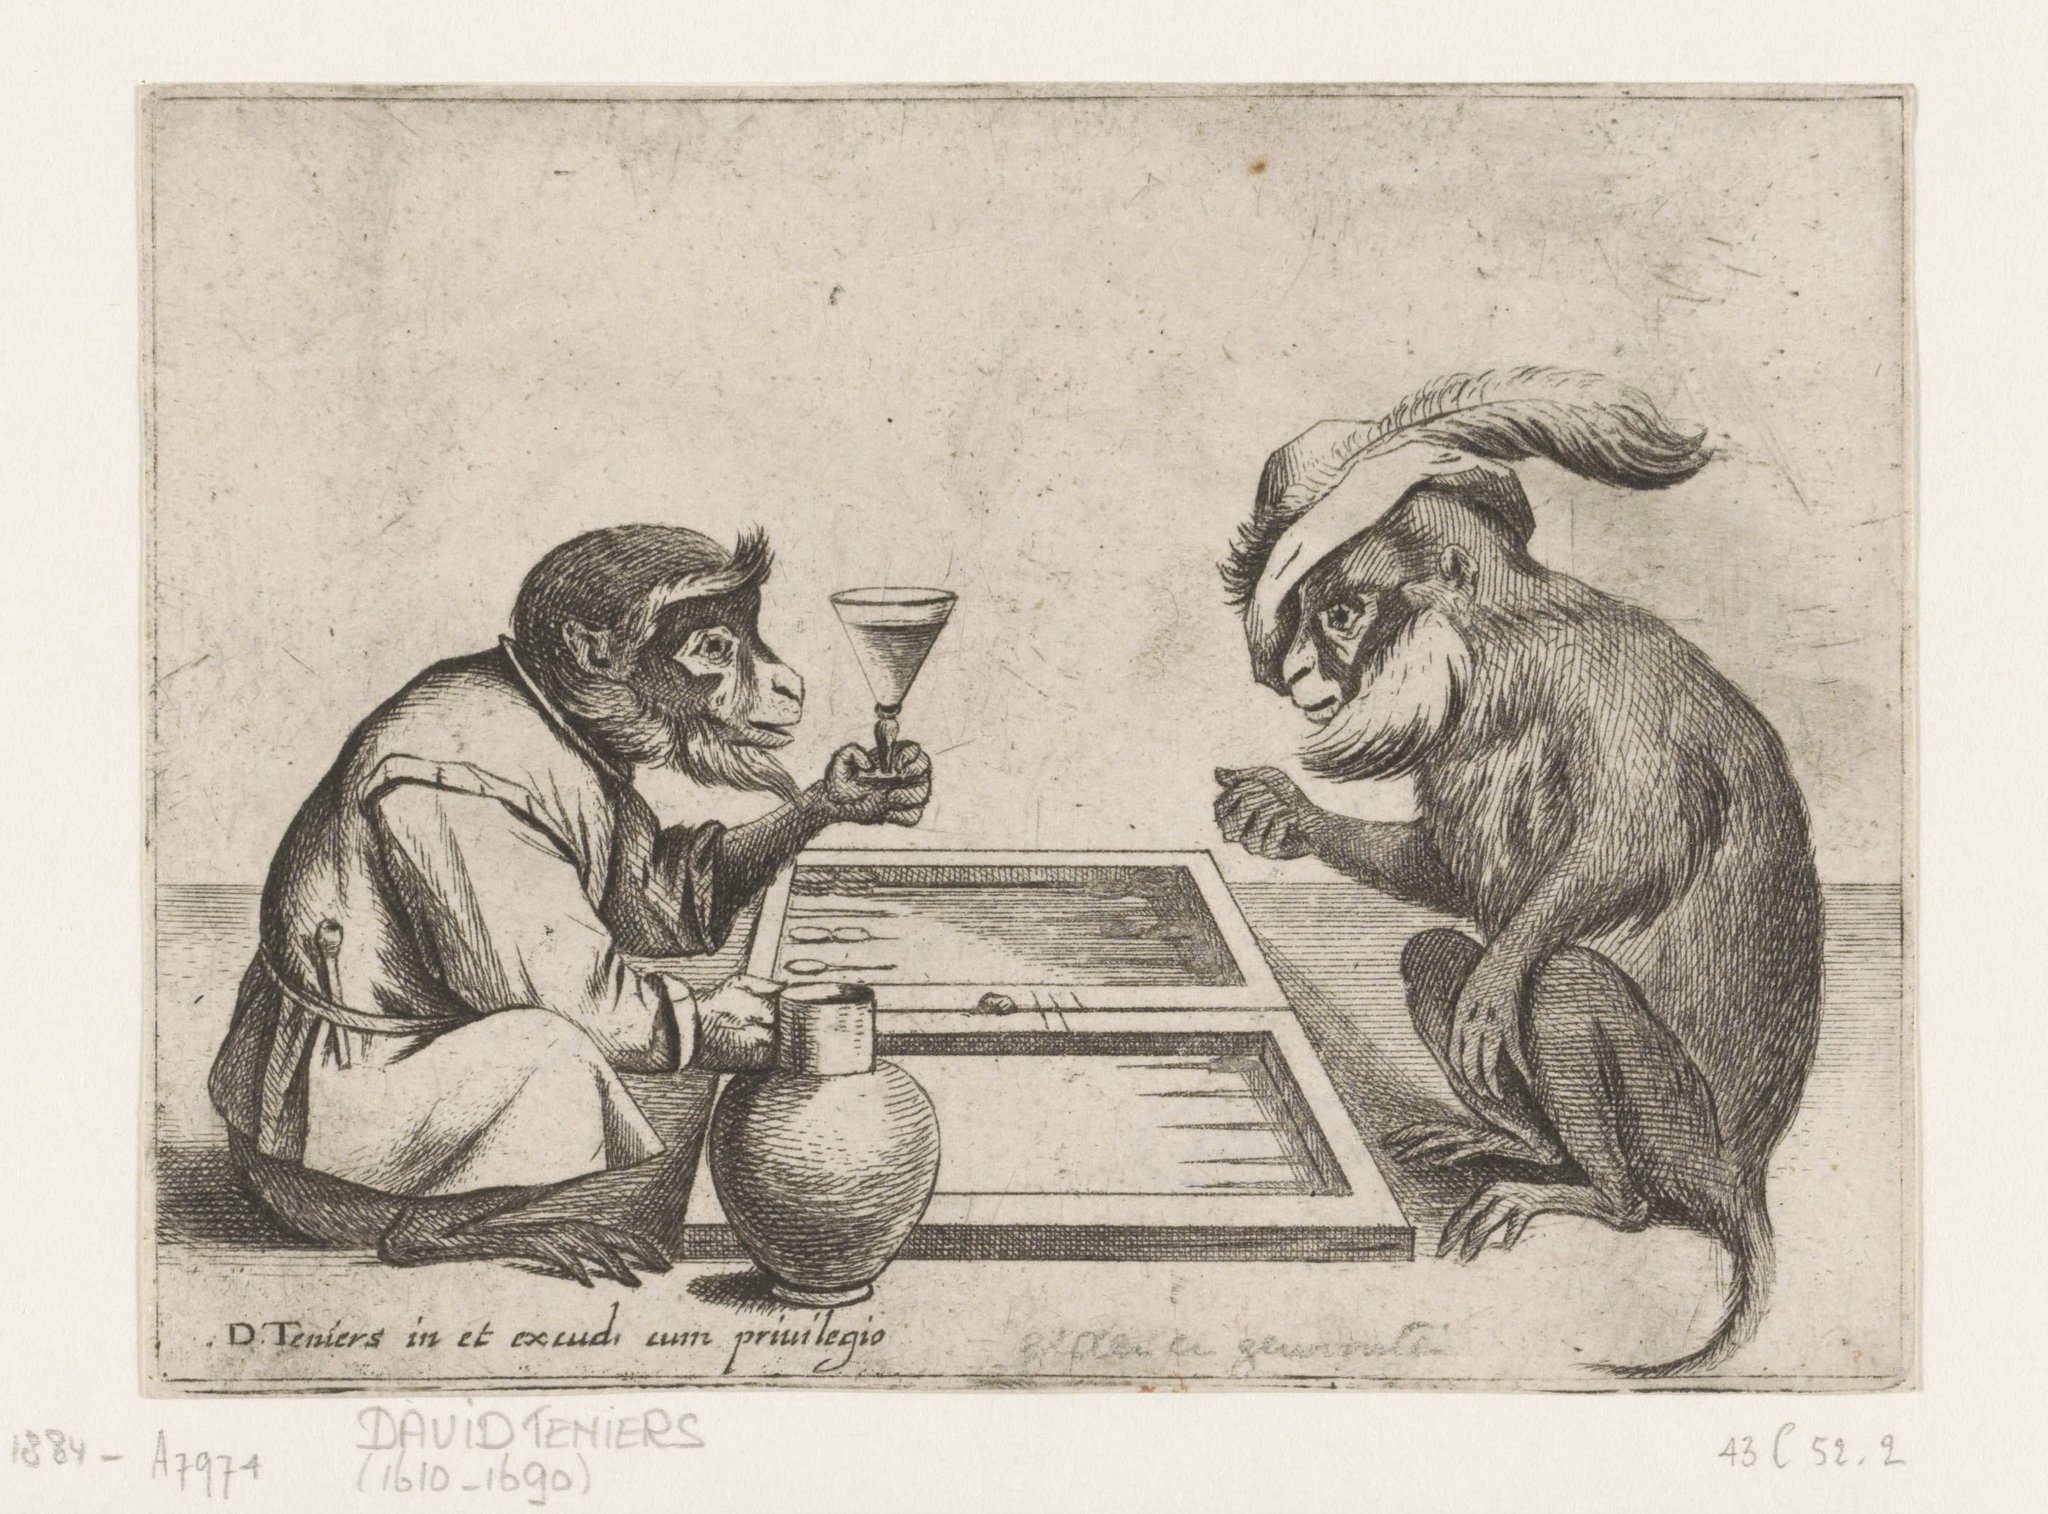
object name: print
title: Tric-trac spelende apen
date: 1630-1688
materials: paper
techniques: engraving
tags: monkeys, apes, animals acting as human beings, backgammon, tric-trac, glass of wine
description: De linkeraap houdt een glas wijn in de hand. De rechter aap heeft een hoed met veer op zijn hoofd. Verschillende bedrijven uit het menschelijke leven door apen voorgesteld. Zes stuks. Naar I. Teniers.